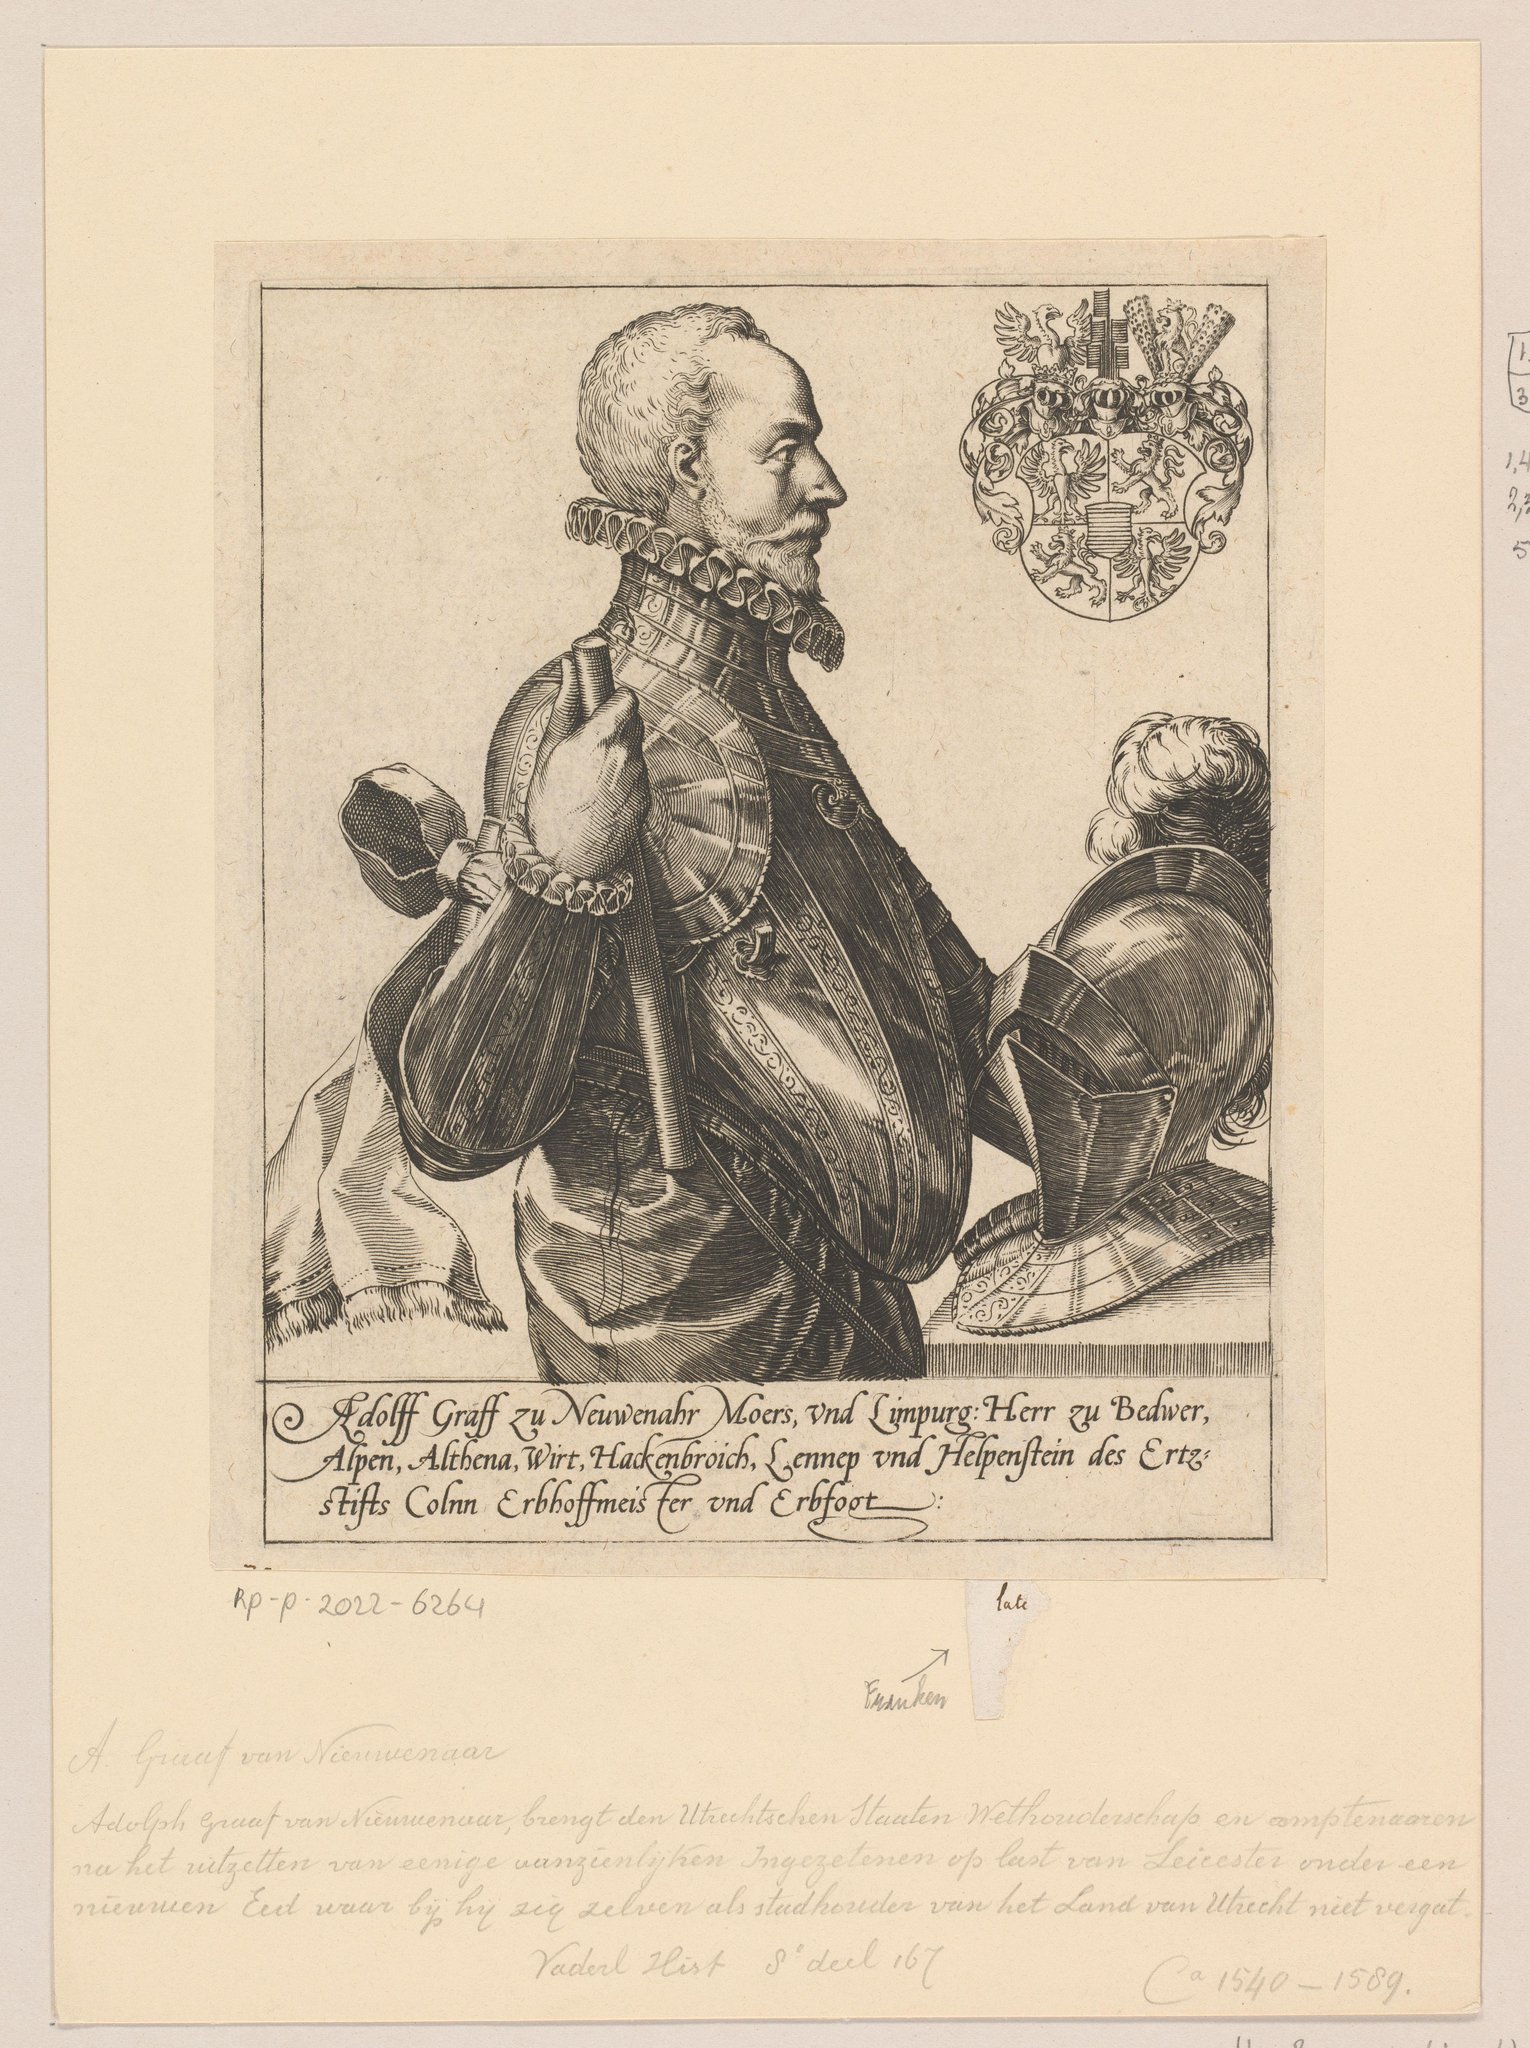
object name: print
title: Portret van Adolf, graaf van Nieuwenaar en Meurs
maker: frans hogenberg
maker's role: print maker, publisher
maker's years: 1538-1590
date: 1584-1620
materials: paper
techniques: engraving, etching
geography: cologne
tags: arnhem, historical persons, diplomacy, diplomat, armorial bearing, heraldry